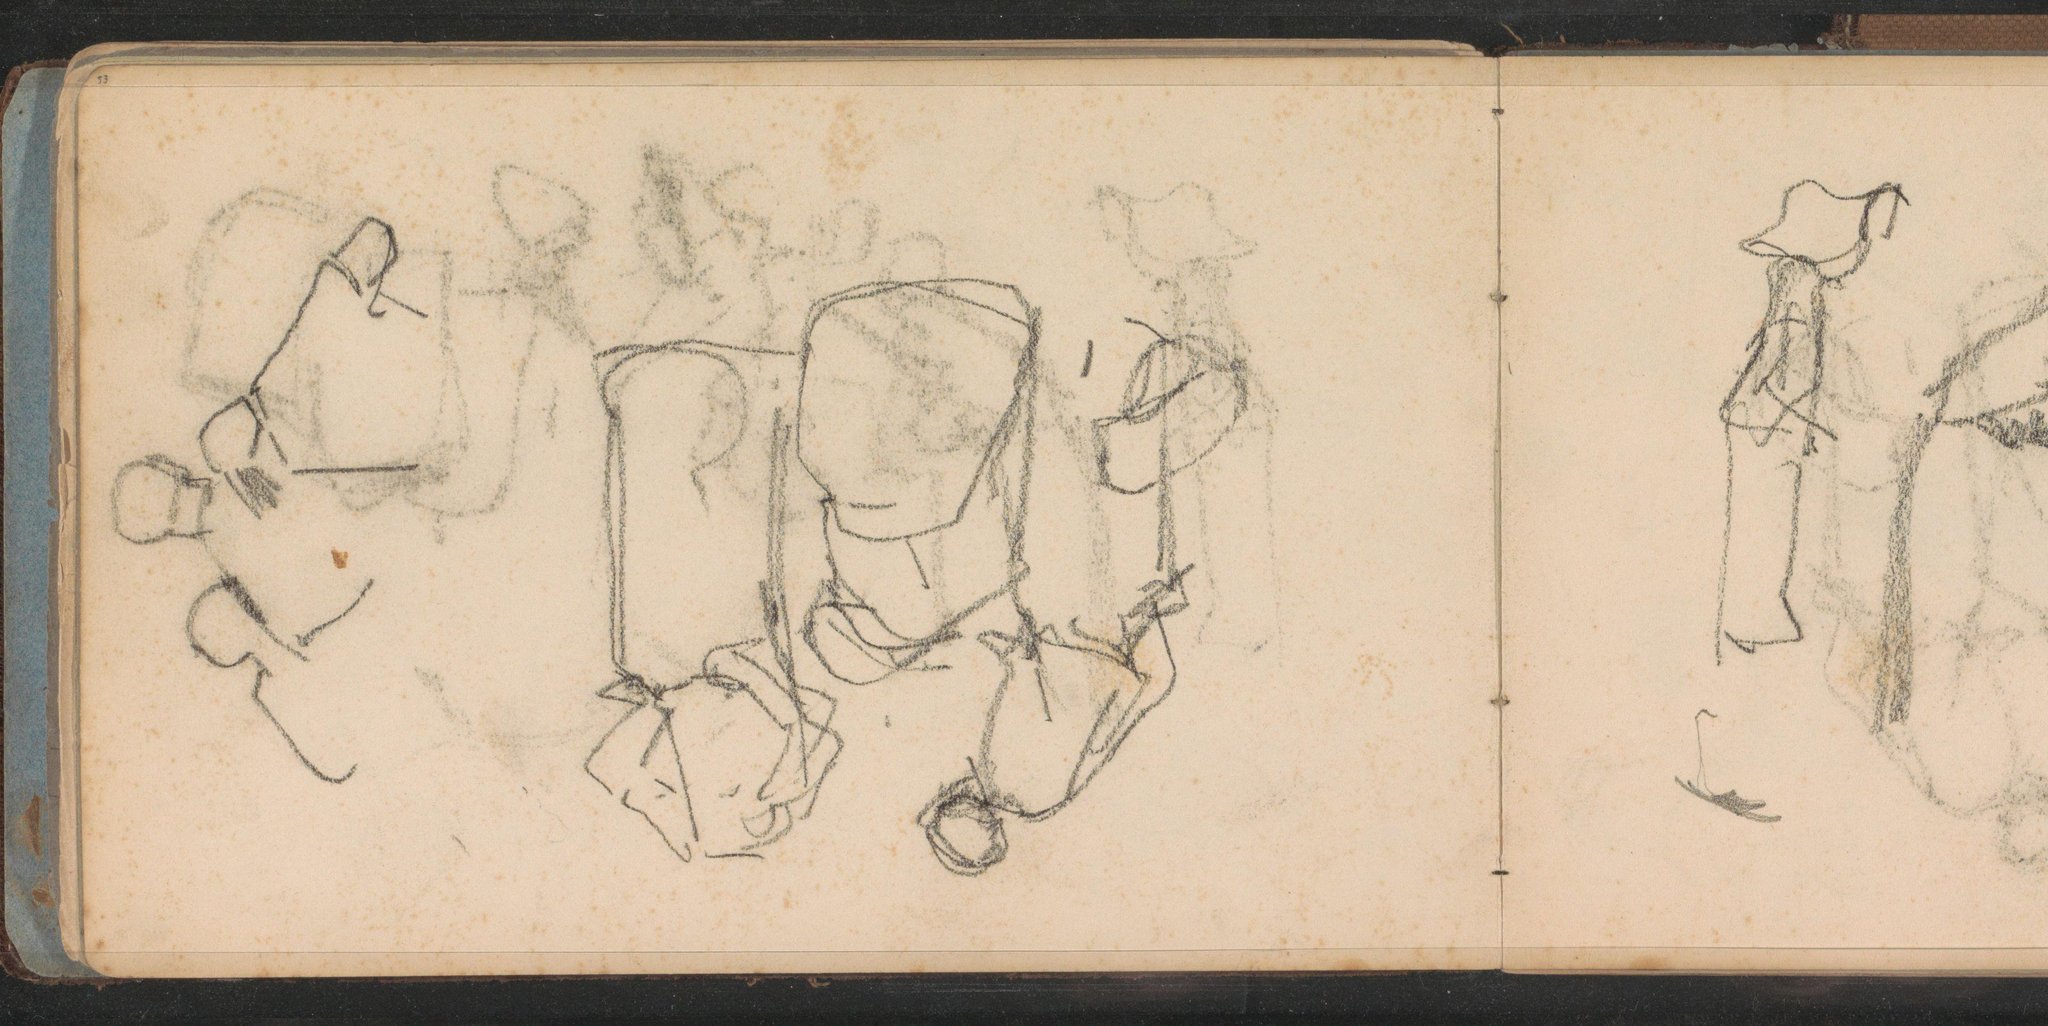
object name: sketchbook leaf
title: Figuurstudies, mogelijk vissersvrouwen die netten boeten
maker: george hendrik breitner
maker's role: draughtsman, painter, print maker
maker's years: 1857-1923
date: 1880-1882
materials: chalk, paper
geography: scheveningen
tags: adult woman, commercial fishery (+ women (labourers)), mending of fishing nets (+ women (labourers))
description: Pagina 33 uit een schetsboek met 37 bladen.